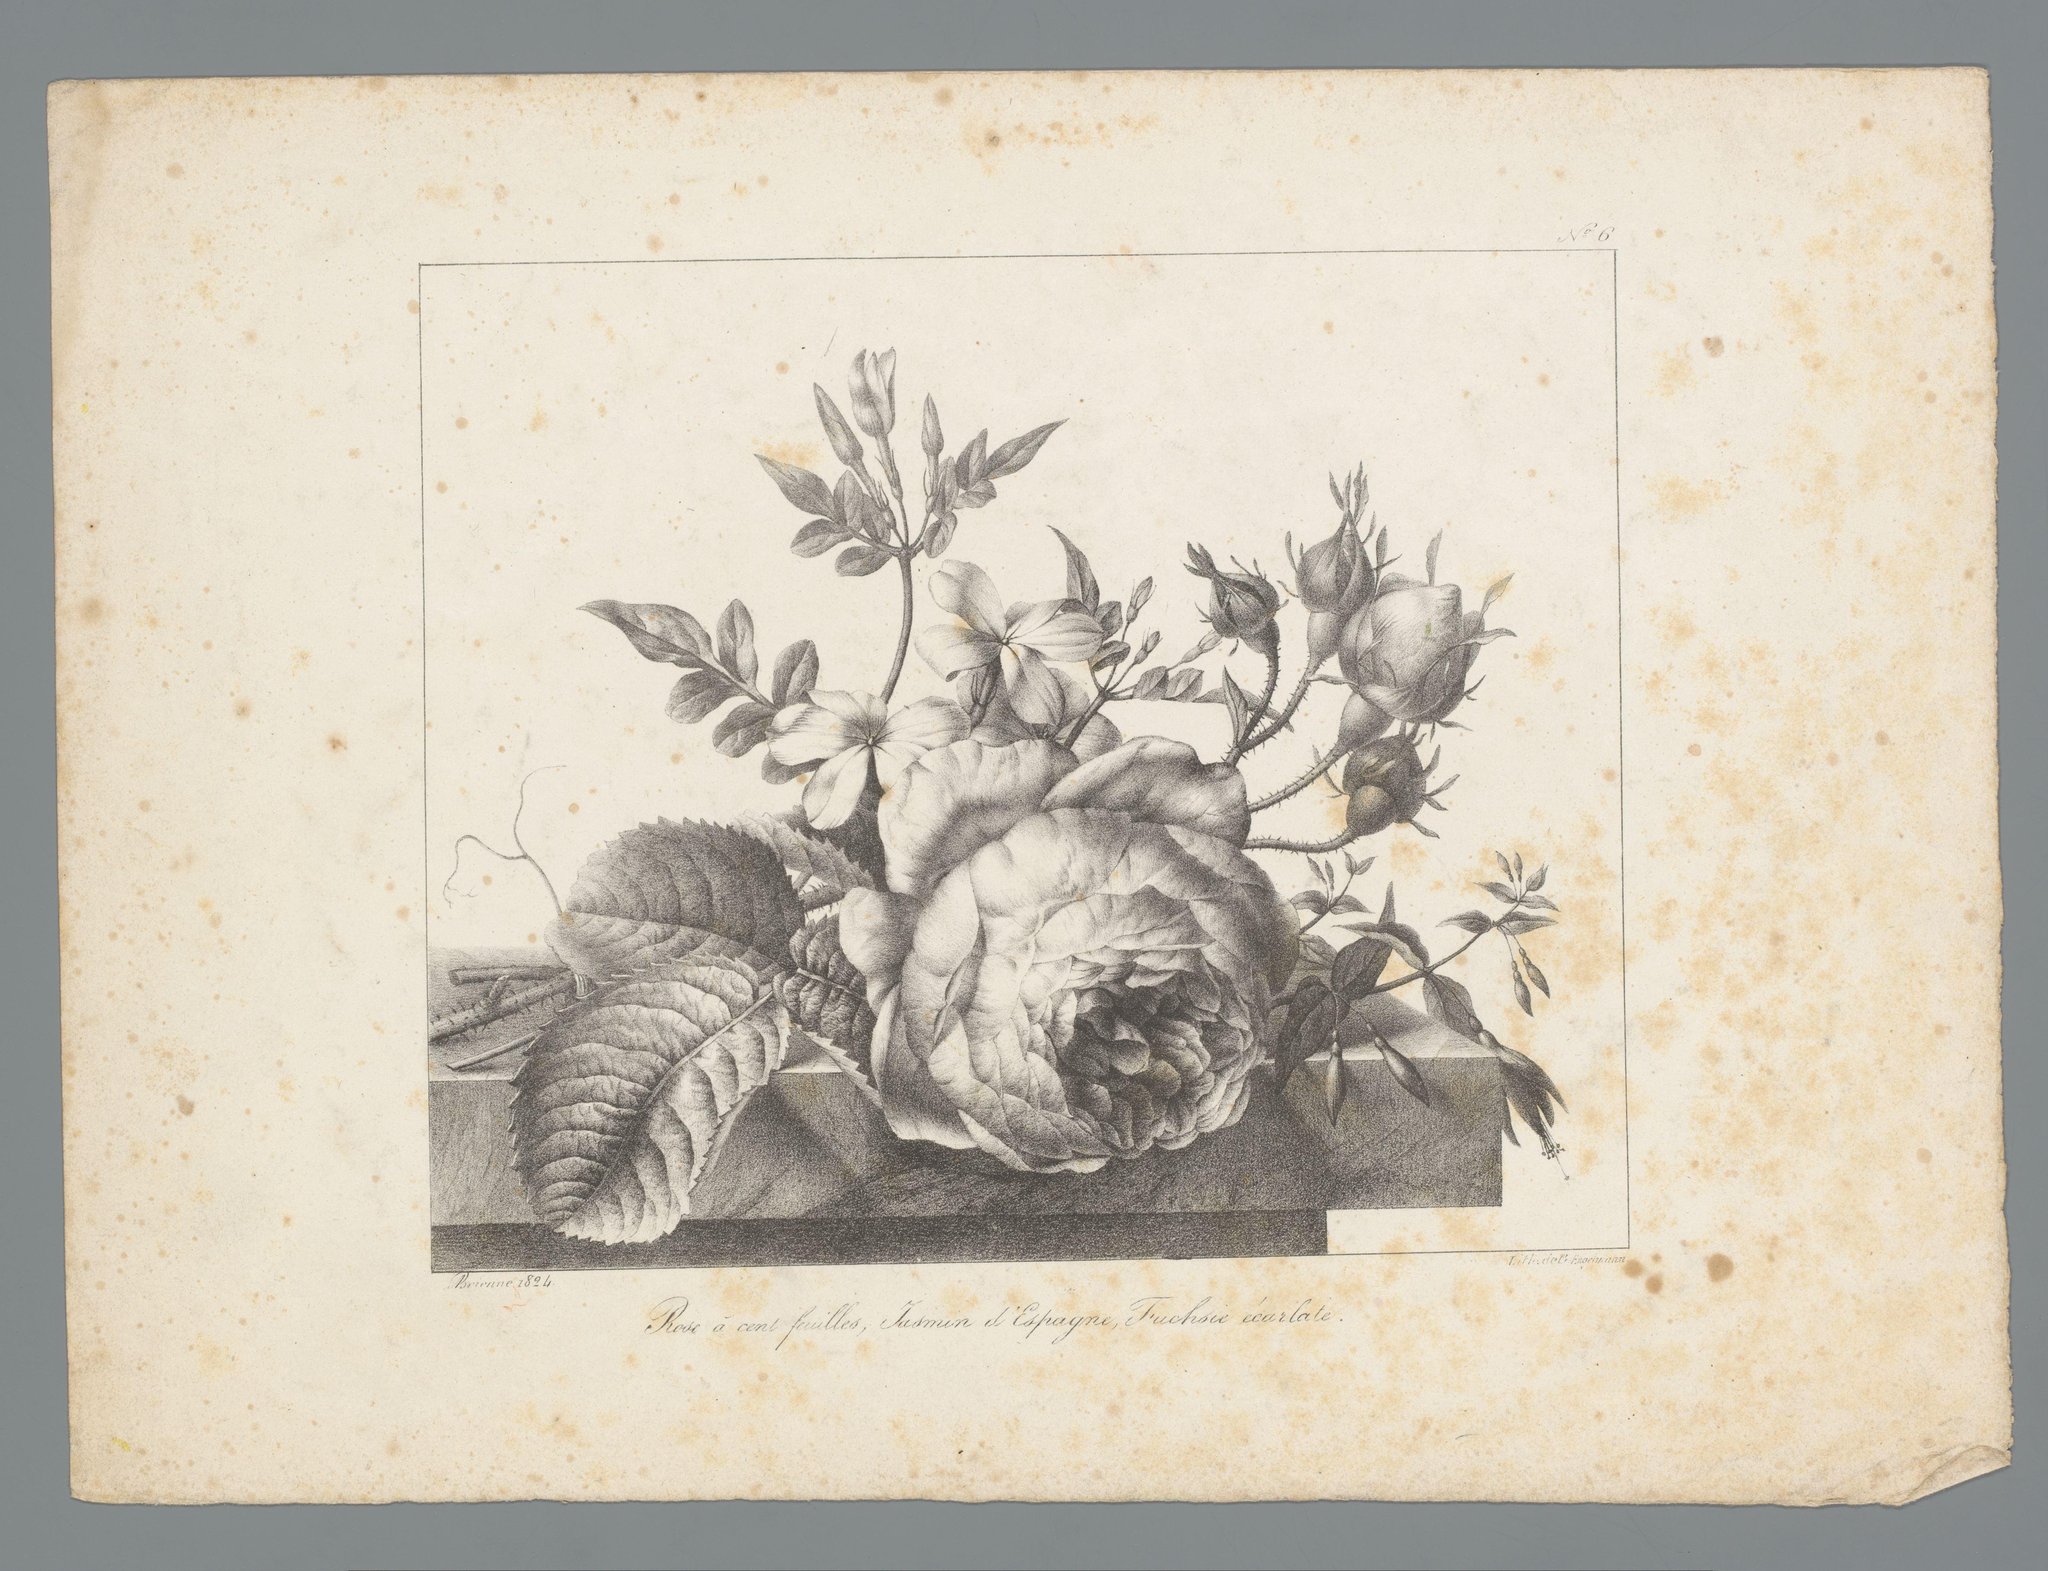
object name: print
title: Rose à cent feuilles, jasmin d'Espagne, fuchsie écarlate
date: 1824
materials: paper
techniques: lithograph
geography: paris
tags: cut flowers; nosegay, bunch of flowers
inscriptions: date